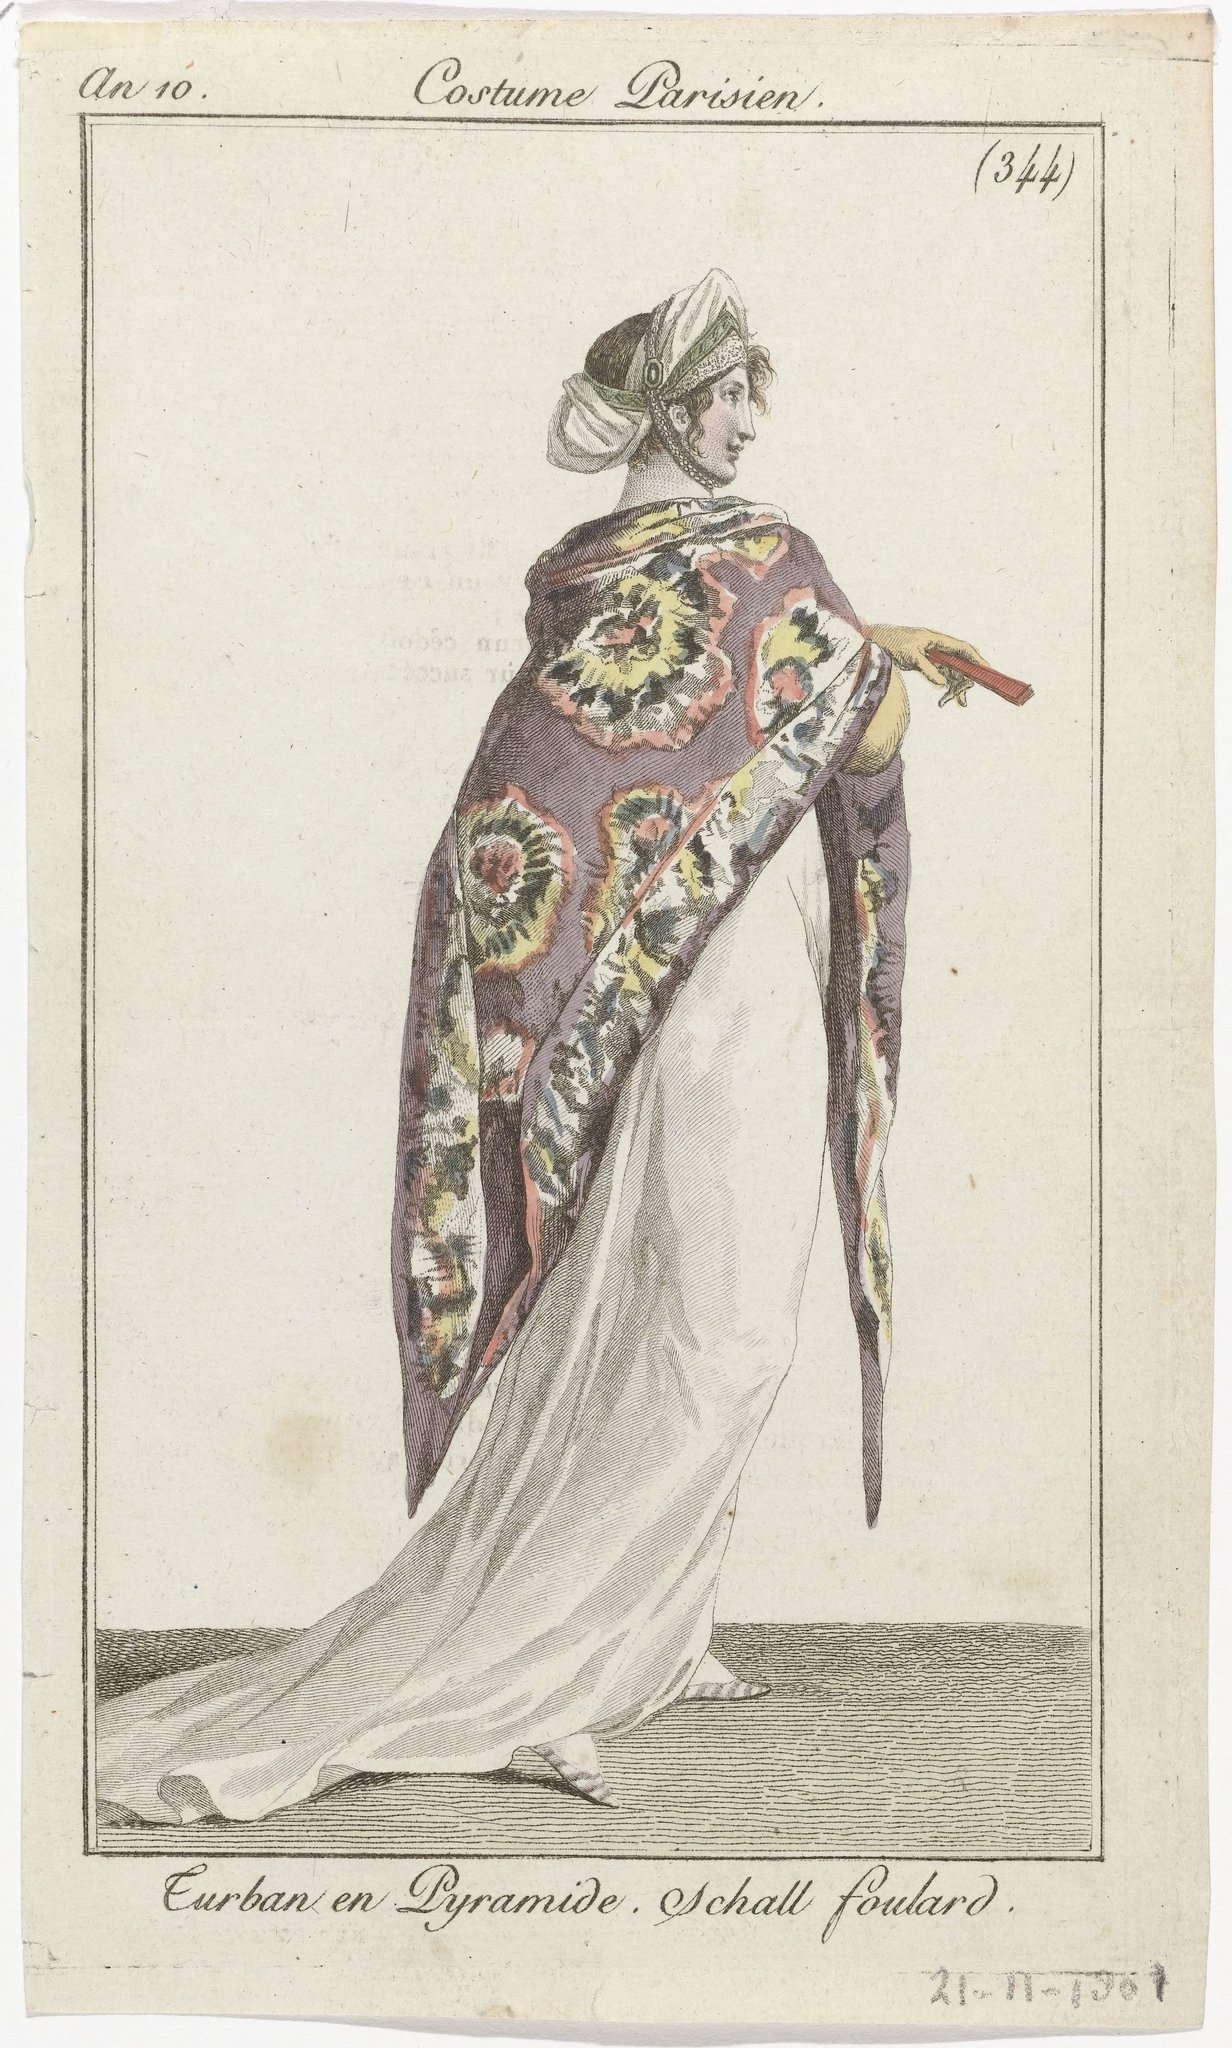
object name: fashion print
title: Journal des Dames et des Modes: Ladies’ Fashion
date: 1801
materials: paper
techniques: engraving, hand coloring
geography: paris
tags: head-gear: turban (+ women's clothes), gloves, mittens (long gloves) (+ women's clothes), clothing for the upper part of the body (shawl) (+ women's clothes), fashion plates, shoes, sandals (+ women's clothes), dress, gown (+ women's clothes), fan (+ women's clothes)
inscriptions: title: ‘Costume Parisien.’, caption: ‘Turban en Pyramide. Schall foulard.’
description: After the turbulent years of the French Revolution, in 1797 a fashion magazine was finally published again: the Journal des Dames et des Modes. Under the direction of Pierre de La Mésangère, it developed a cosmopolitan flair. The very best draughtsmen were recruited to produce the fashion illustrations, called Costumes Parisiens. They visited spots all over Paris to ensure they saw the latest styles. These included high-waisted gowns with low necklines, ‘Greek’ slippers with cross-laces 1, genuine Kashmiri shawls 2, reticules 3 (small stylish handbags), poke bonnets 4 and full-length English coats knowns as redingotes 5.